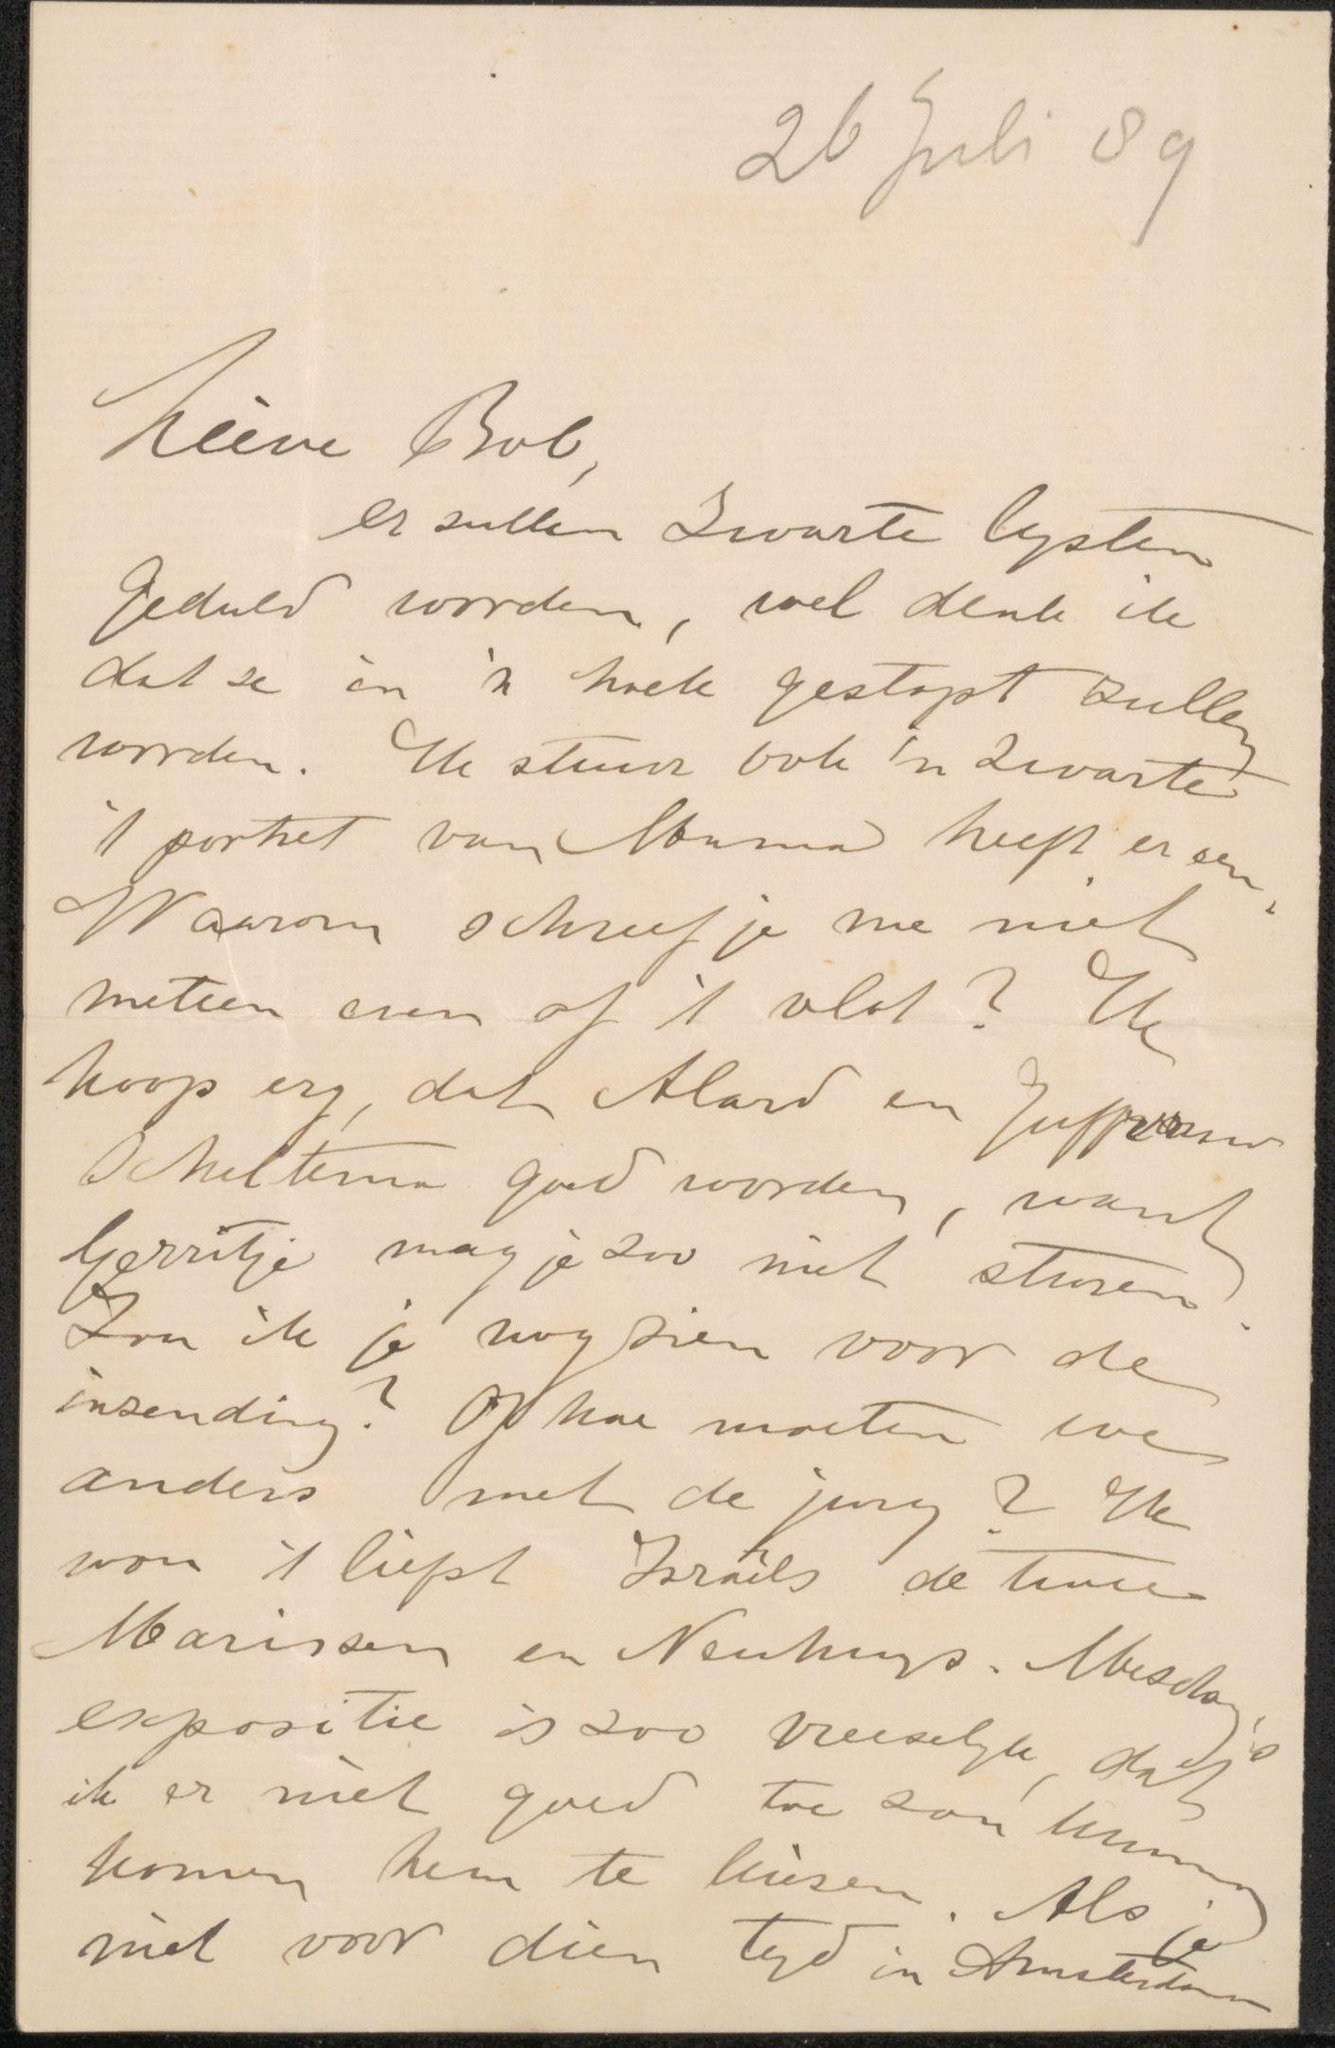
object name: letter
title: Brief aan Jan Veth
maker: wally moes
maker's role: draughtsman, print maker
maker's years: 1856-1918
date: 1874-1918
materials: ink, paper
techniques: pen, writing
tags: dordrecht, painter, print maker, draughtsman, designer, jan veth, hendrik willem mesdag, london, matthijs maris, jacob maris, utrecht, albert neuhuys (1844-1914), amsterdam, allard pierson, artist, anna dorothea dirks, exhibition ~ art, historical persons (portraits and scenes from the life)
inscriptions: collector's mark: ‘RPK’